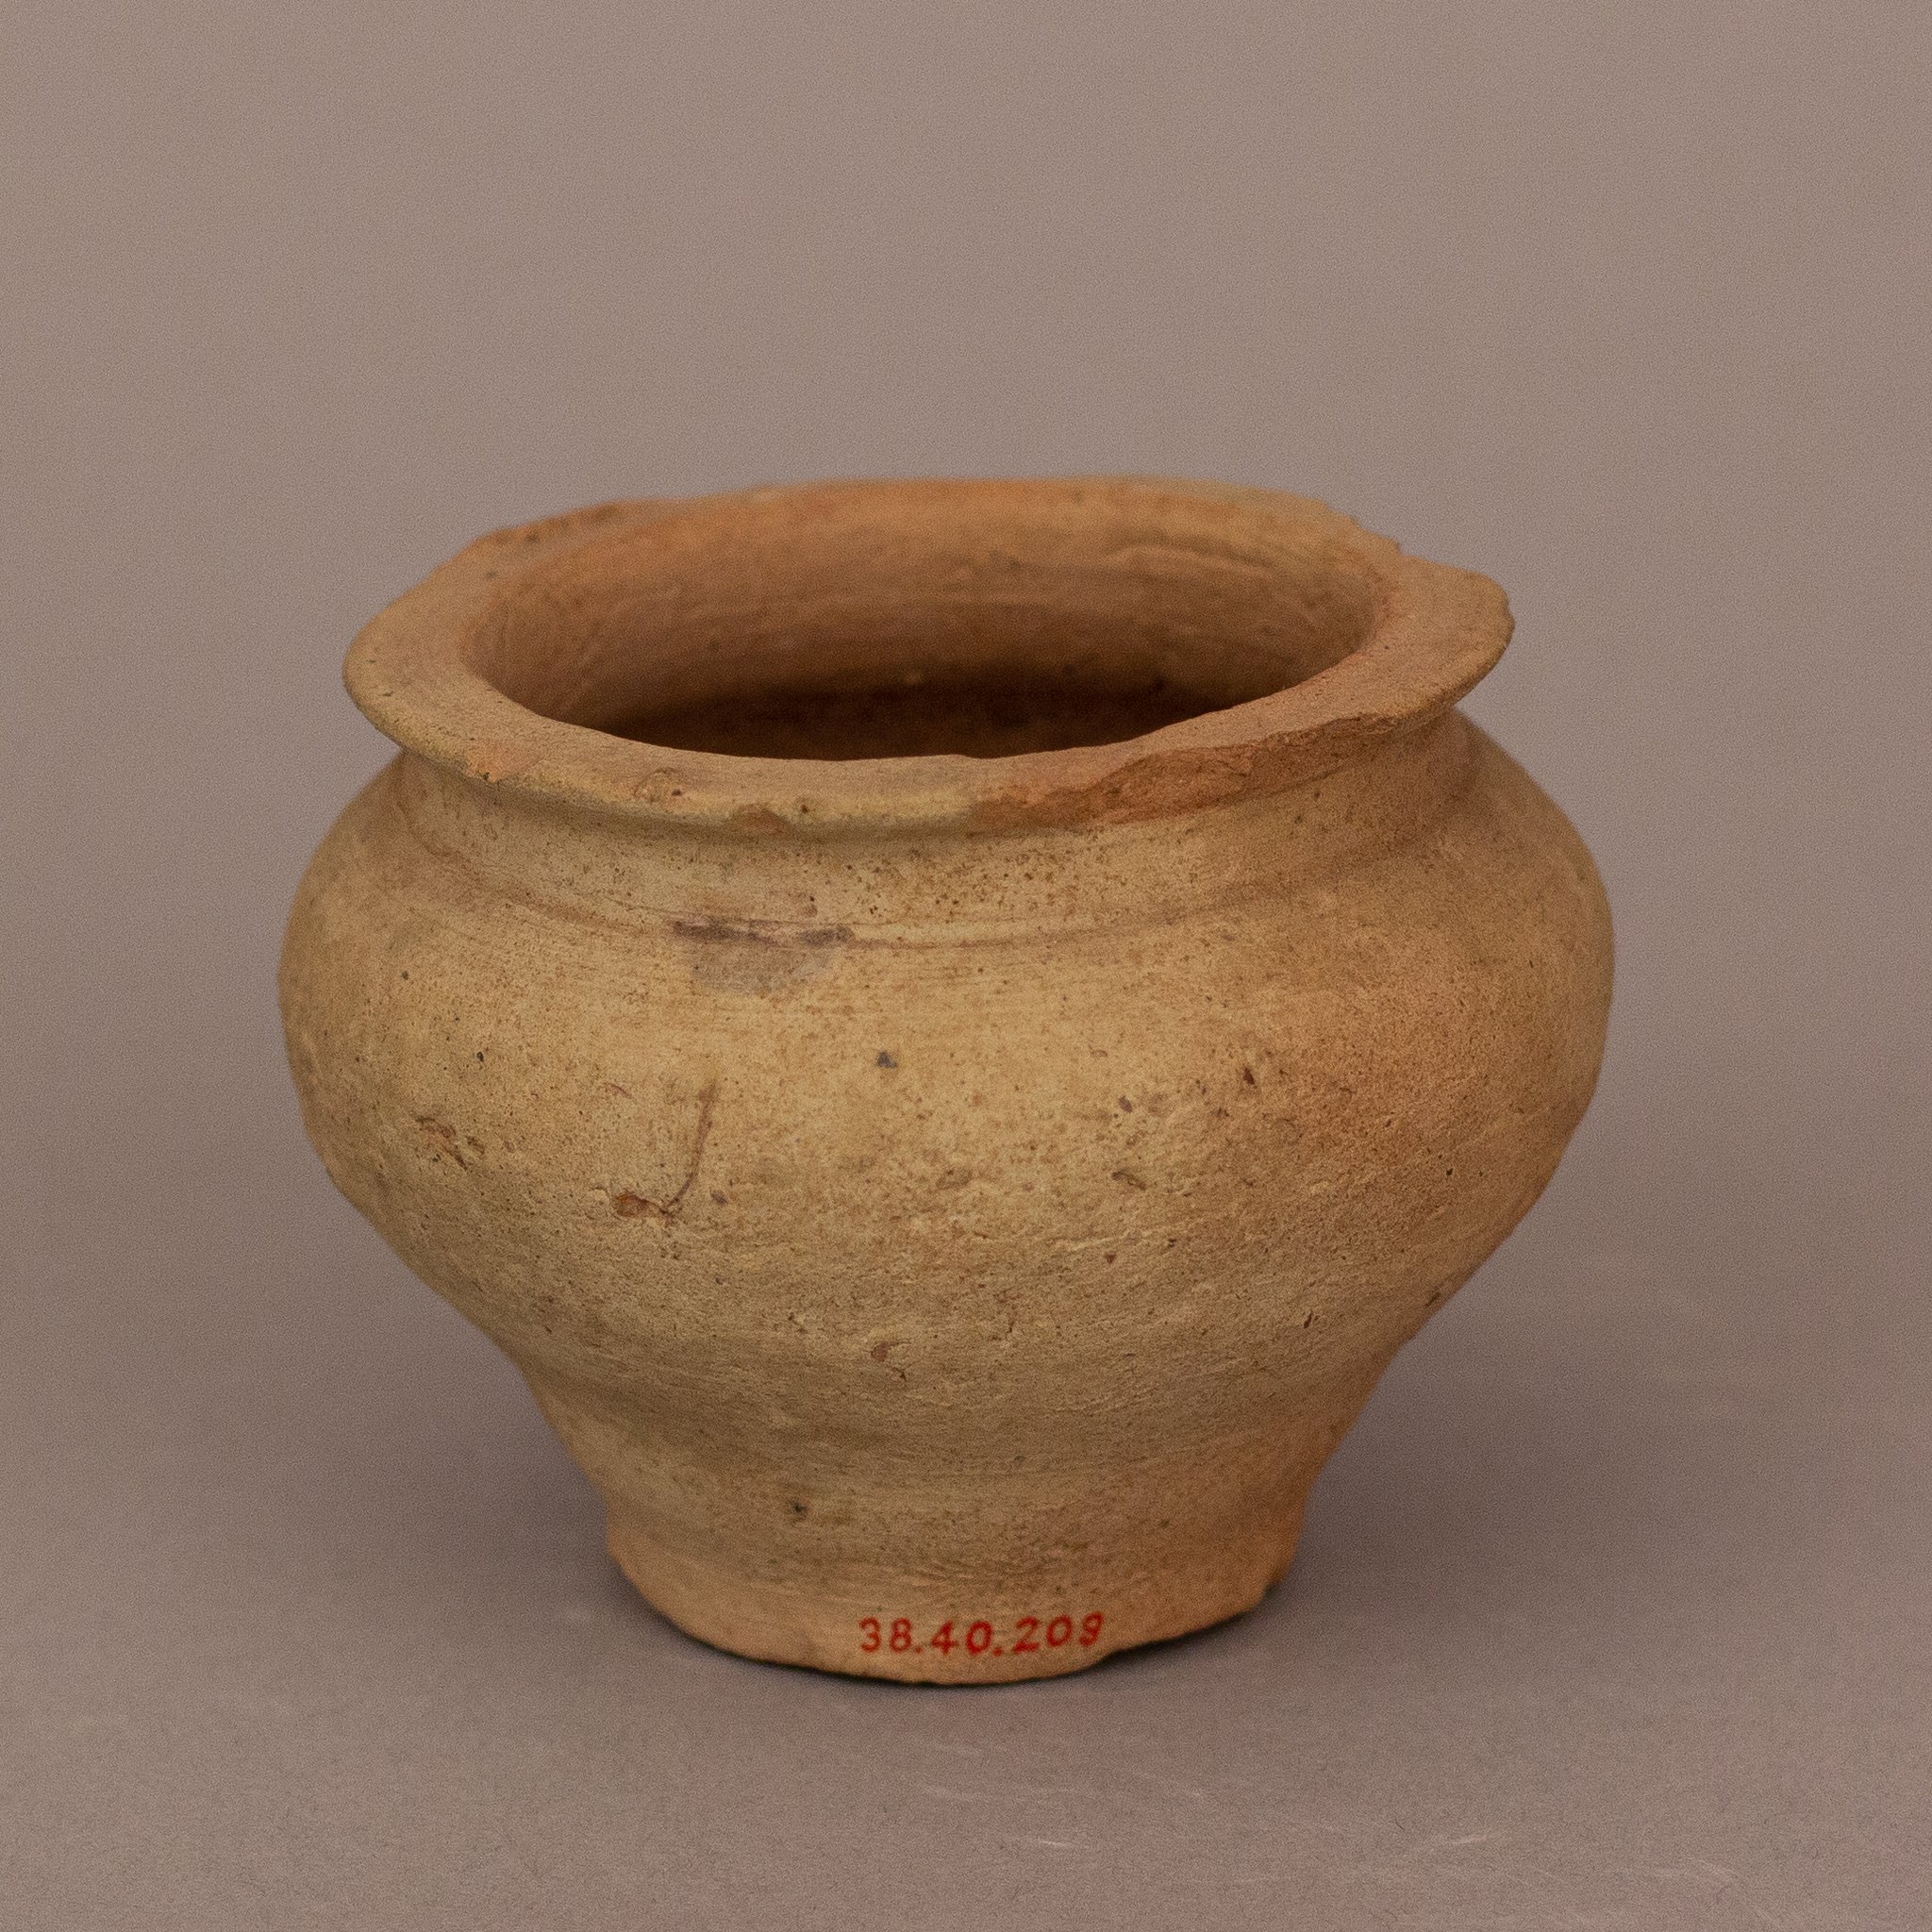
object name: jar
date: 801-900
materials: earthenware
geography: iran